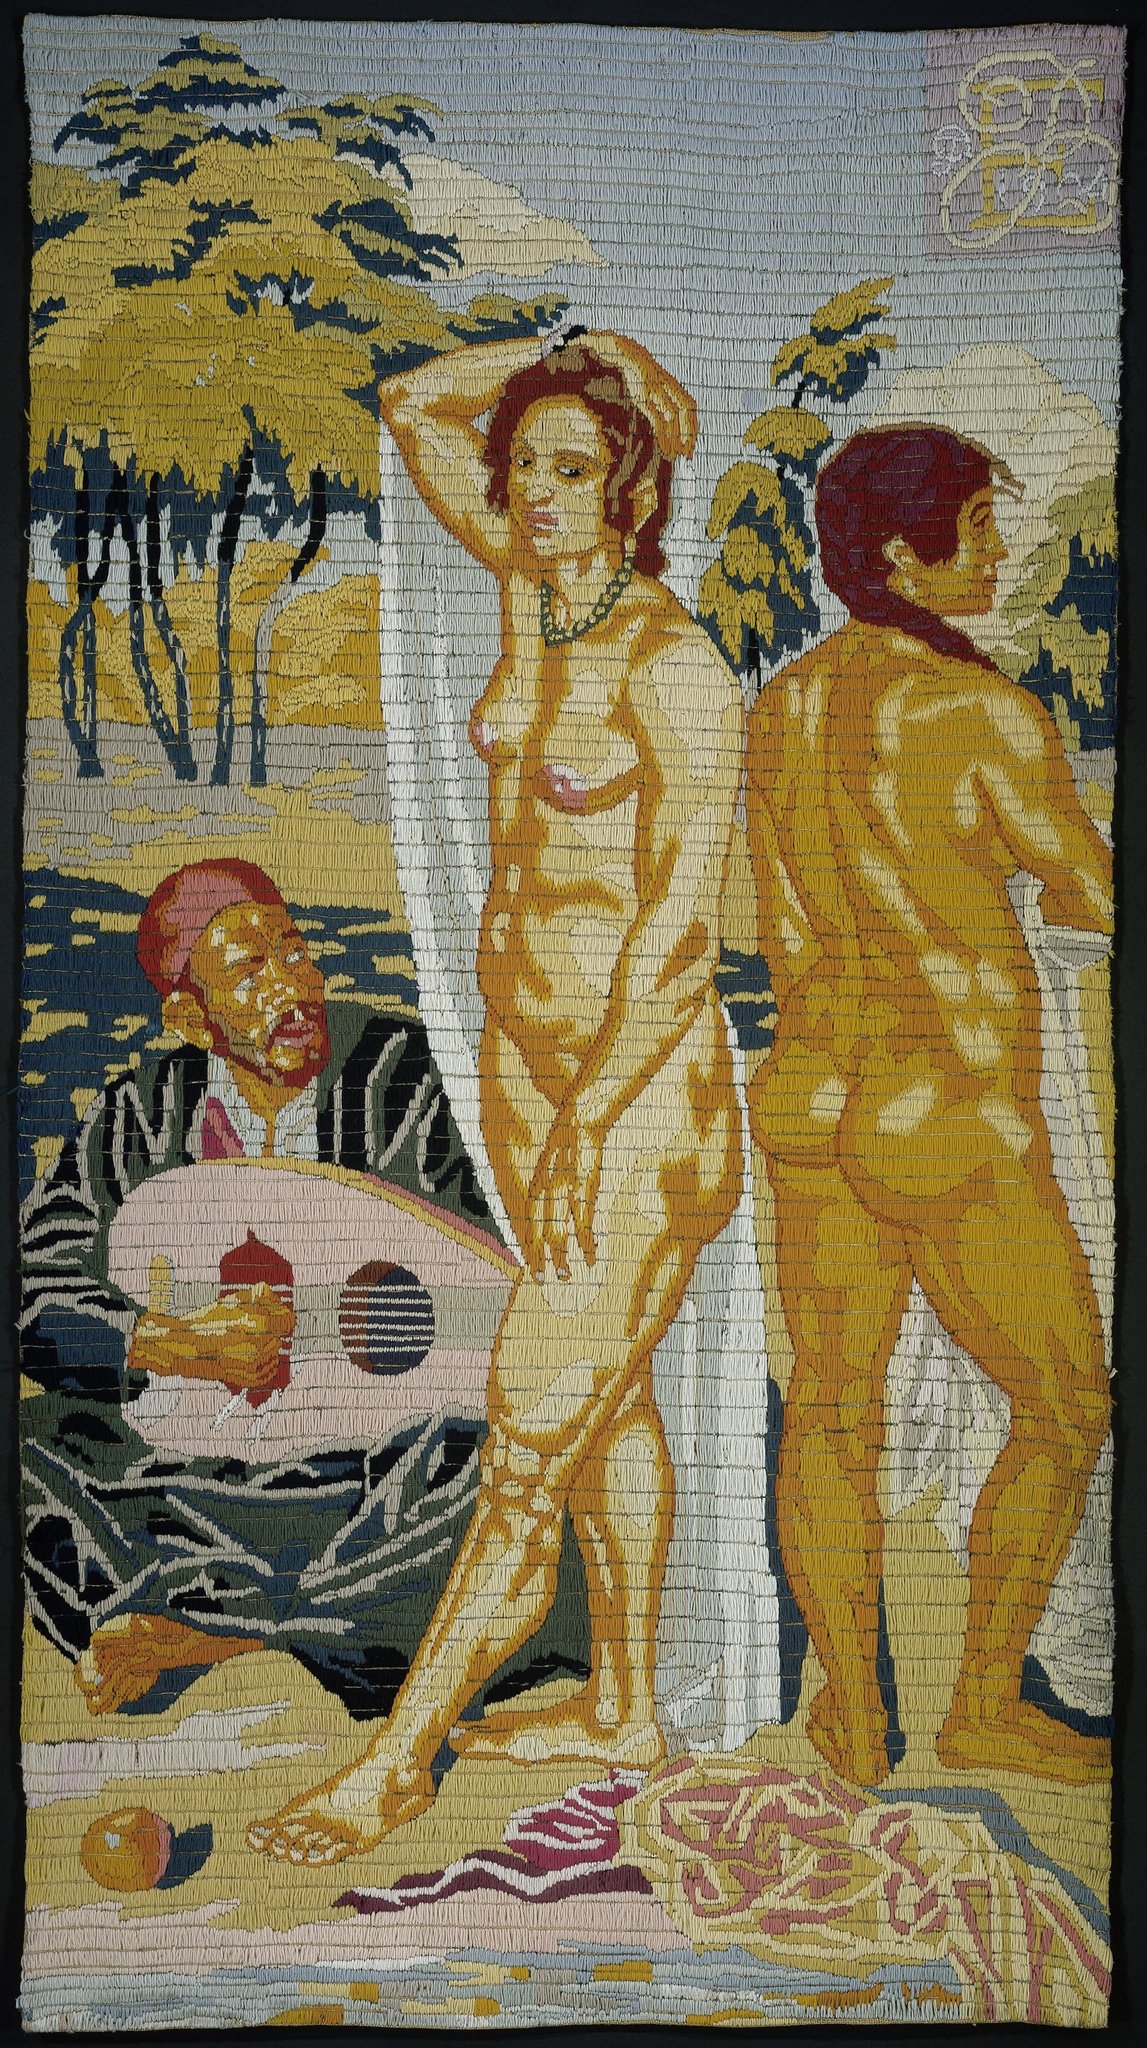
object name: tableau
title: Geborduurd tableau; Deux Baigneuses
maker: émile bernard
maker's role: print maker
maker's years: 1868-1941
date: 1904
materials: wool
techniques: embroidered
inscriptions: date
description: Tableau van wol borduursel op een stramien. In een landschap staan rechts twee naakte vrouwen. Een van de vrouwen is op de rug gezien en de andere van voren met haar rechterarm steunend op haar hoofd en een blauwe sluier vasthoudend. Een zittende man speelt op een luit, voor hem ligt een vrucht. Het tableau is in de rechter bovenhoek gemerkt: EB 1904 TQ.